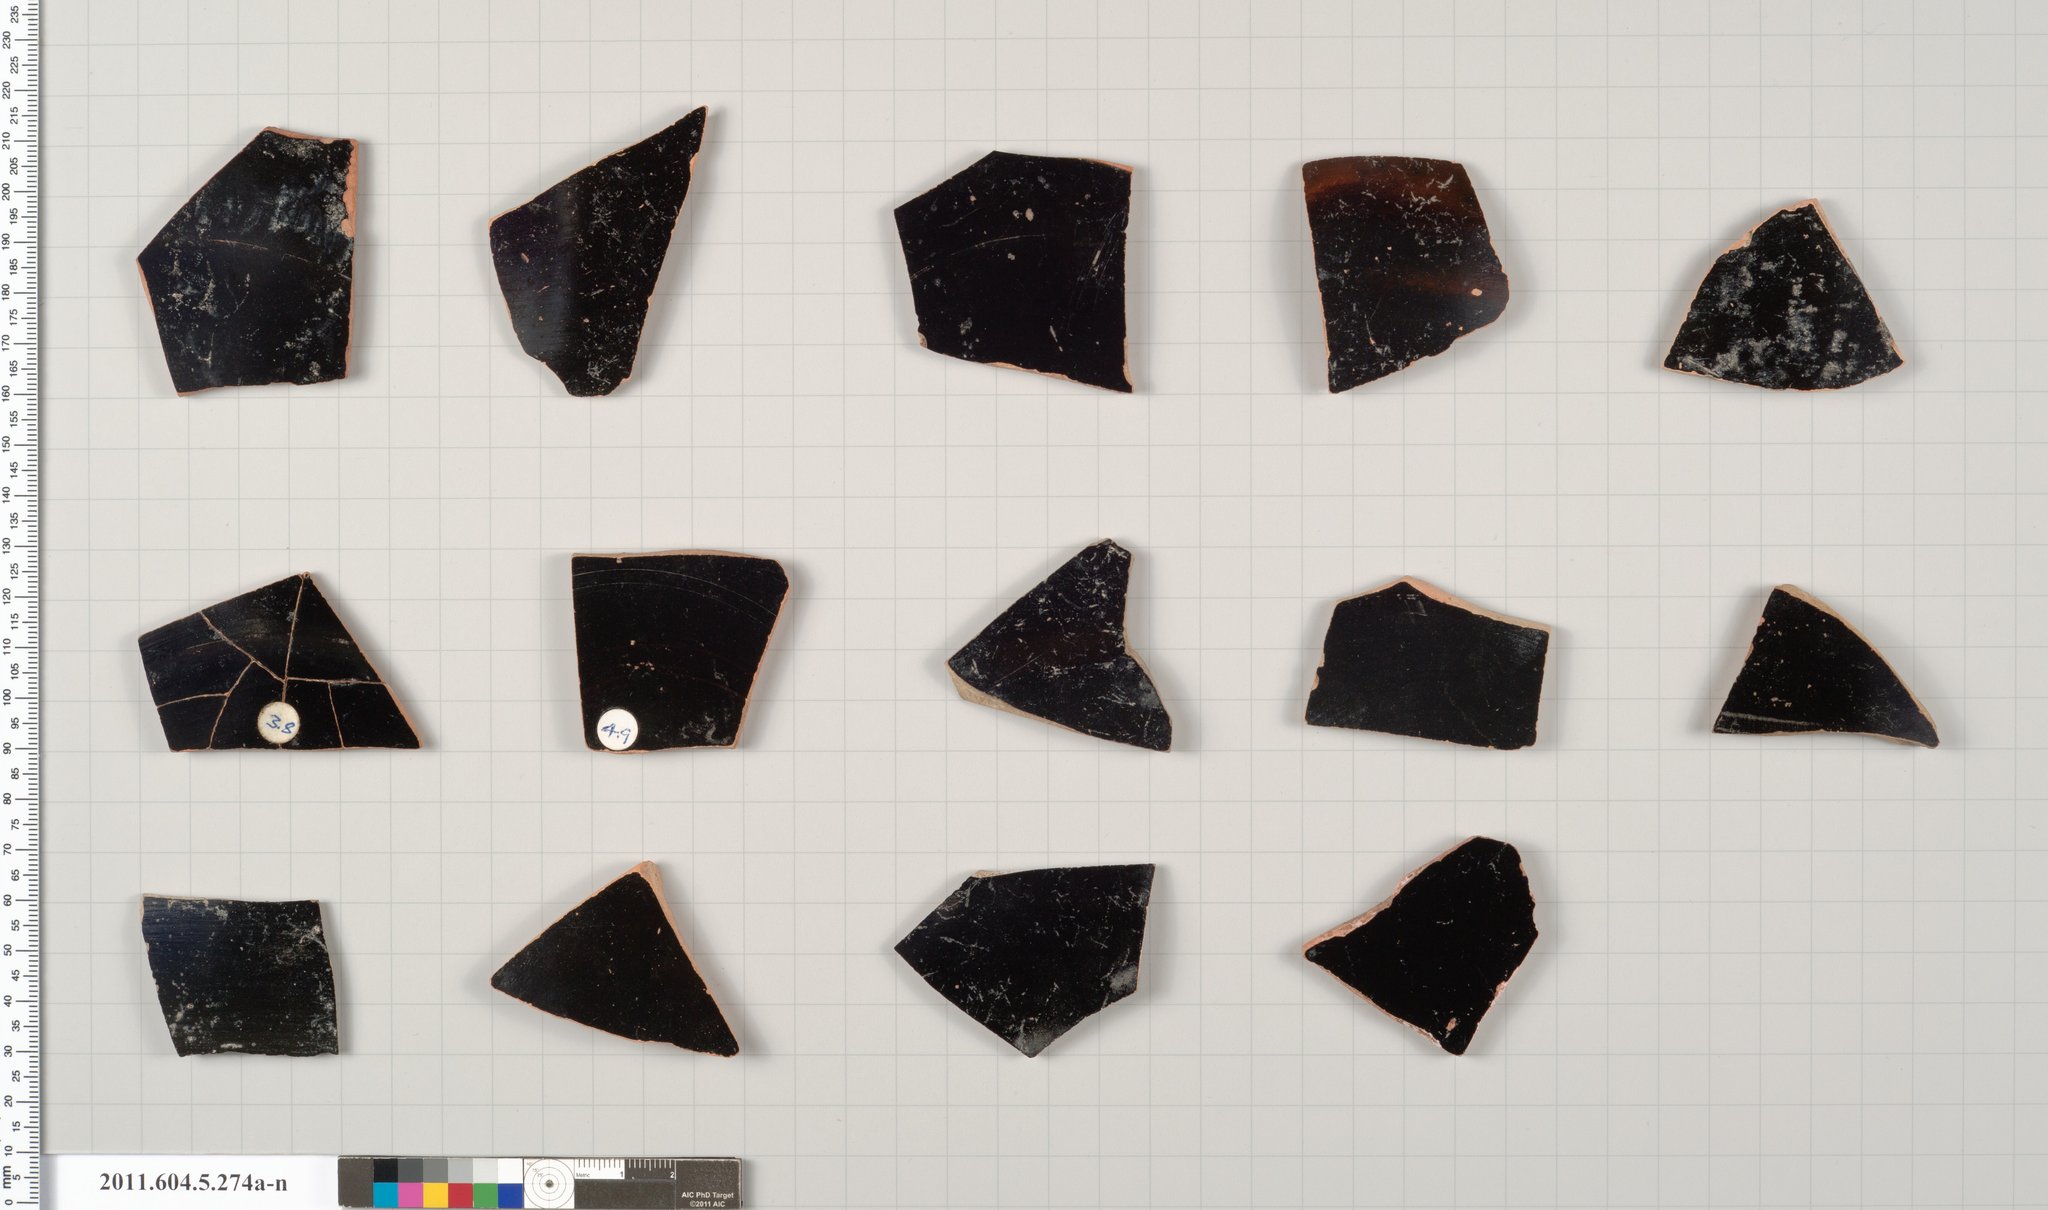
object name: kylix fragment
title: Terracotta fragments of kylikes (drinking cups)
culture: greek, attic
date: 600-401 BCE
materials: terracotta